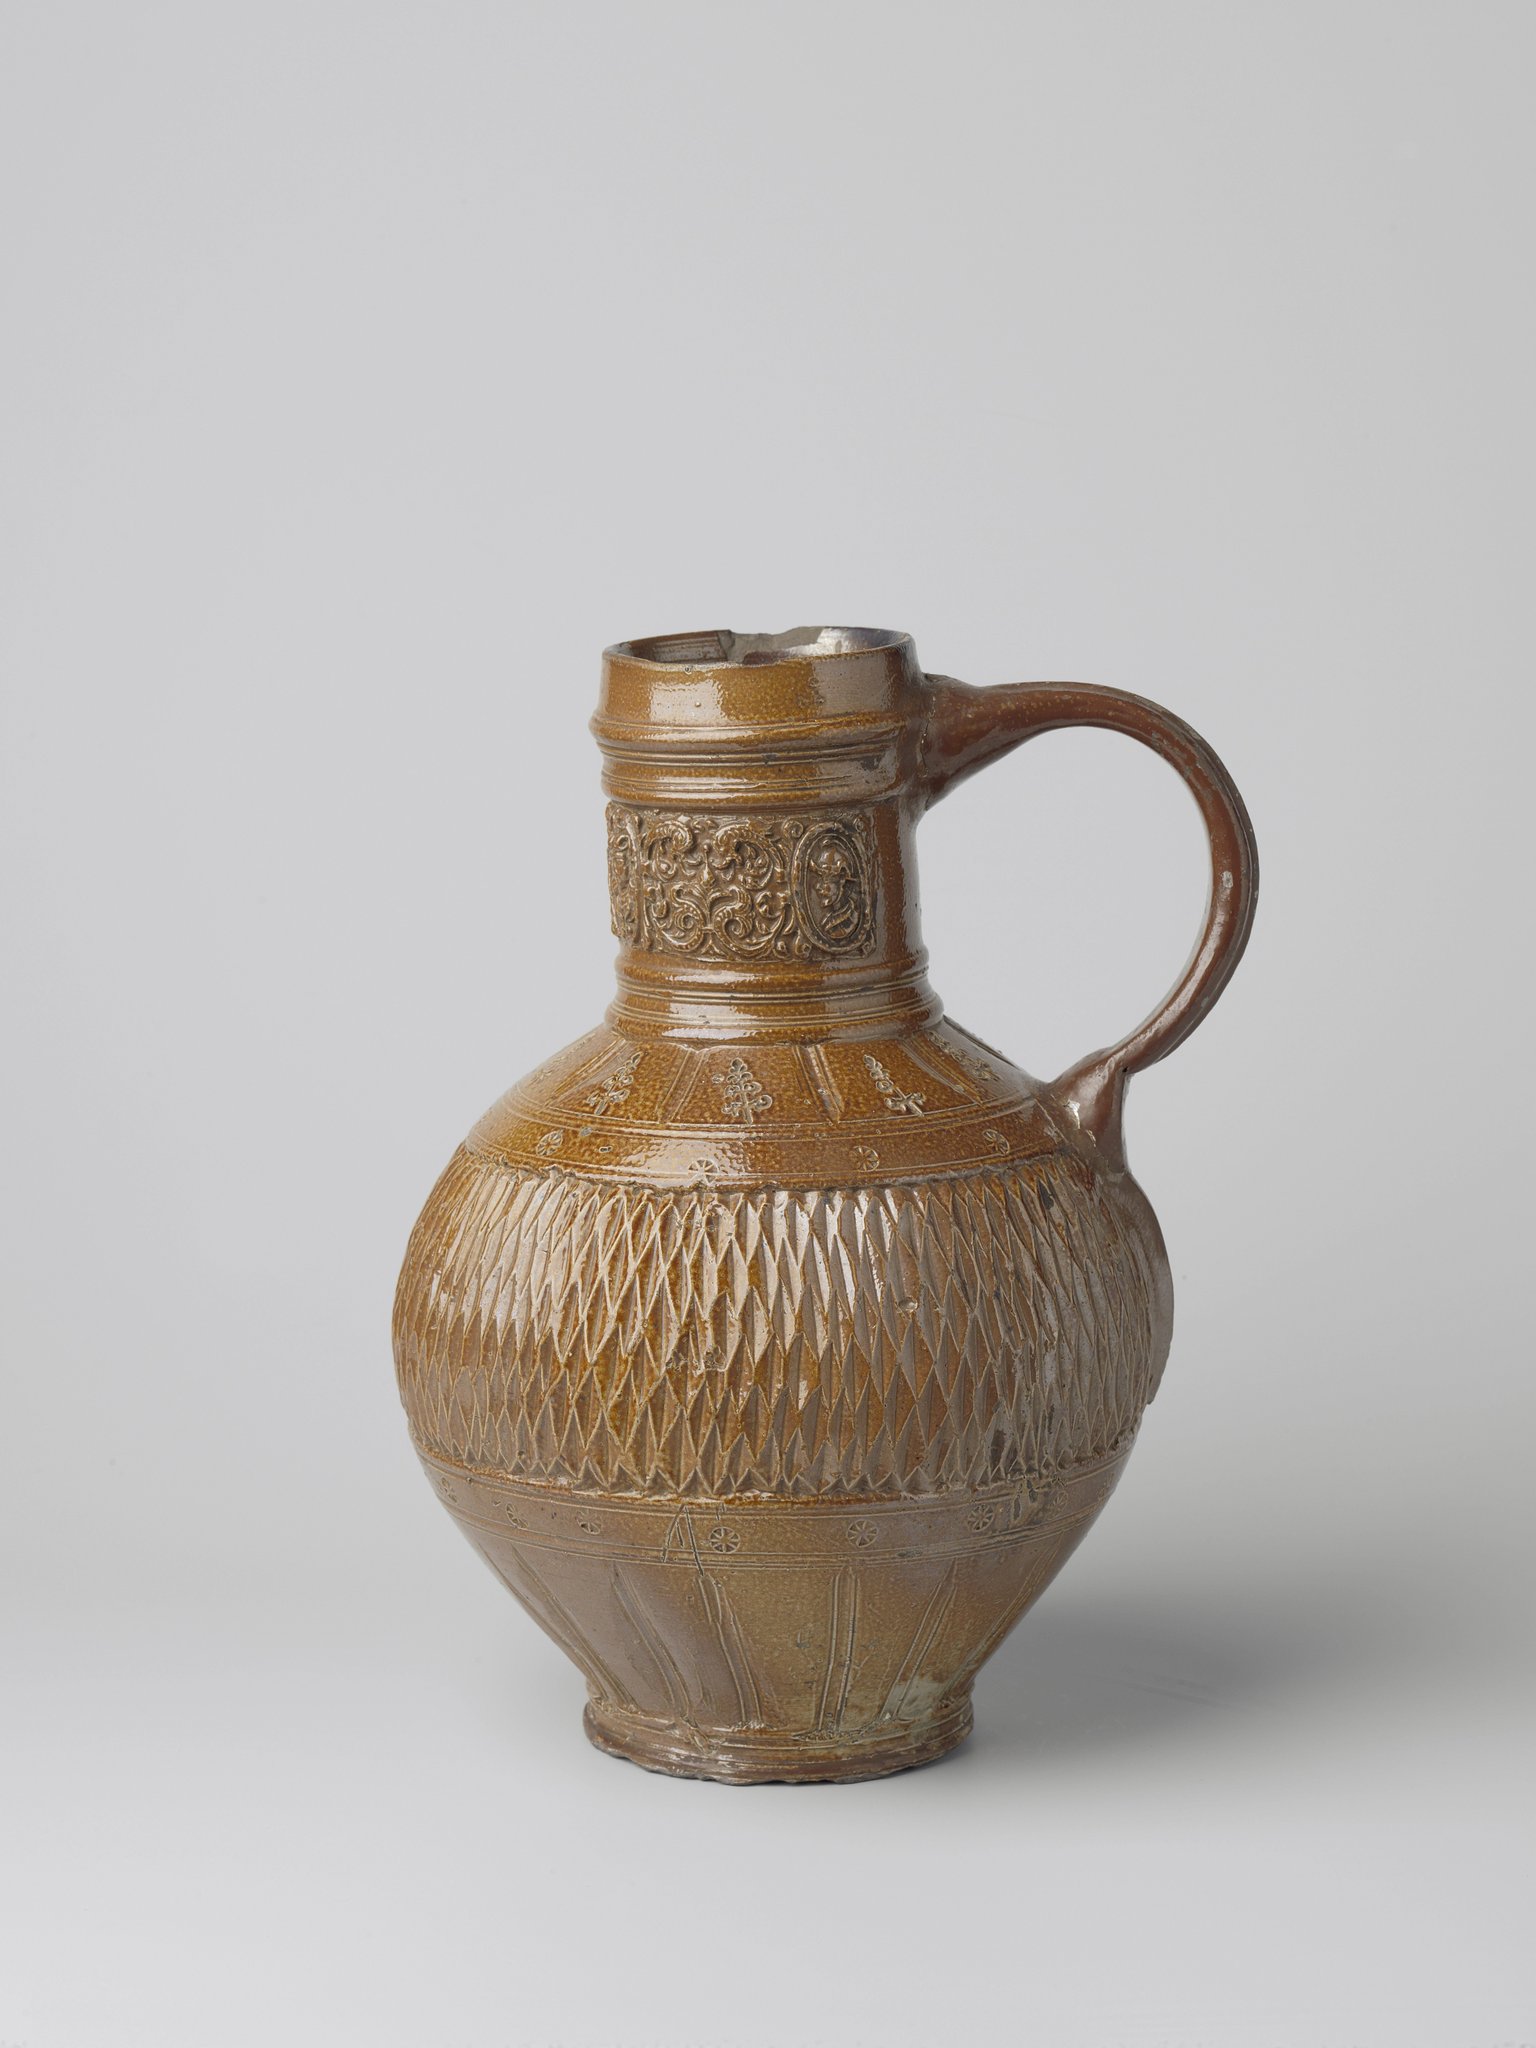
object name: jug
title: Jug with foliate scrolls, masks and chip carving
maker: Anonymous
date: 1590-1620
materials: engobe, glaze, stoneware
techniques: printing, firing, forming, relief, turning, vitrification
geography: raeren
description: Kruik van steengoed op standring met een bolvormig lichaam en wijde nek. Het C-vormige oor is bevestigd aan de nek en de schouder. Enkele profielen op de nek en voet. Bedekt met een bruine engobe. Op de buik een brede band met kerfsnede, daaronder en -boven een band met gestempelde rozetten. De schouder en het onderste deel van de buik met ingegrifte vakken, op de schouder gevuld met gestileerde ranken. Op de nek in reliëf een gedrukte en opgelegde band met bladranken onderbroken door maskers in medaillons. Bodem ontbreekt. Raeren.